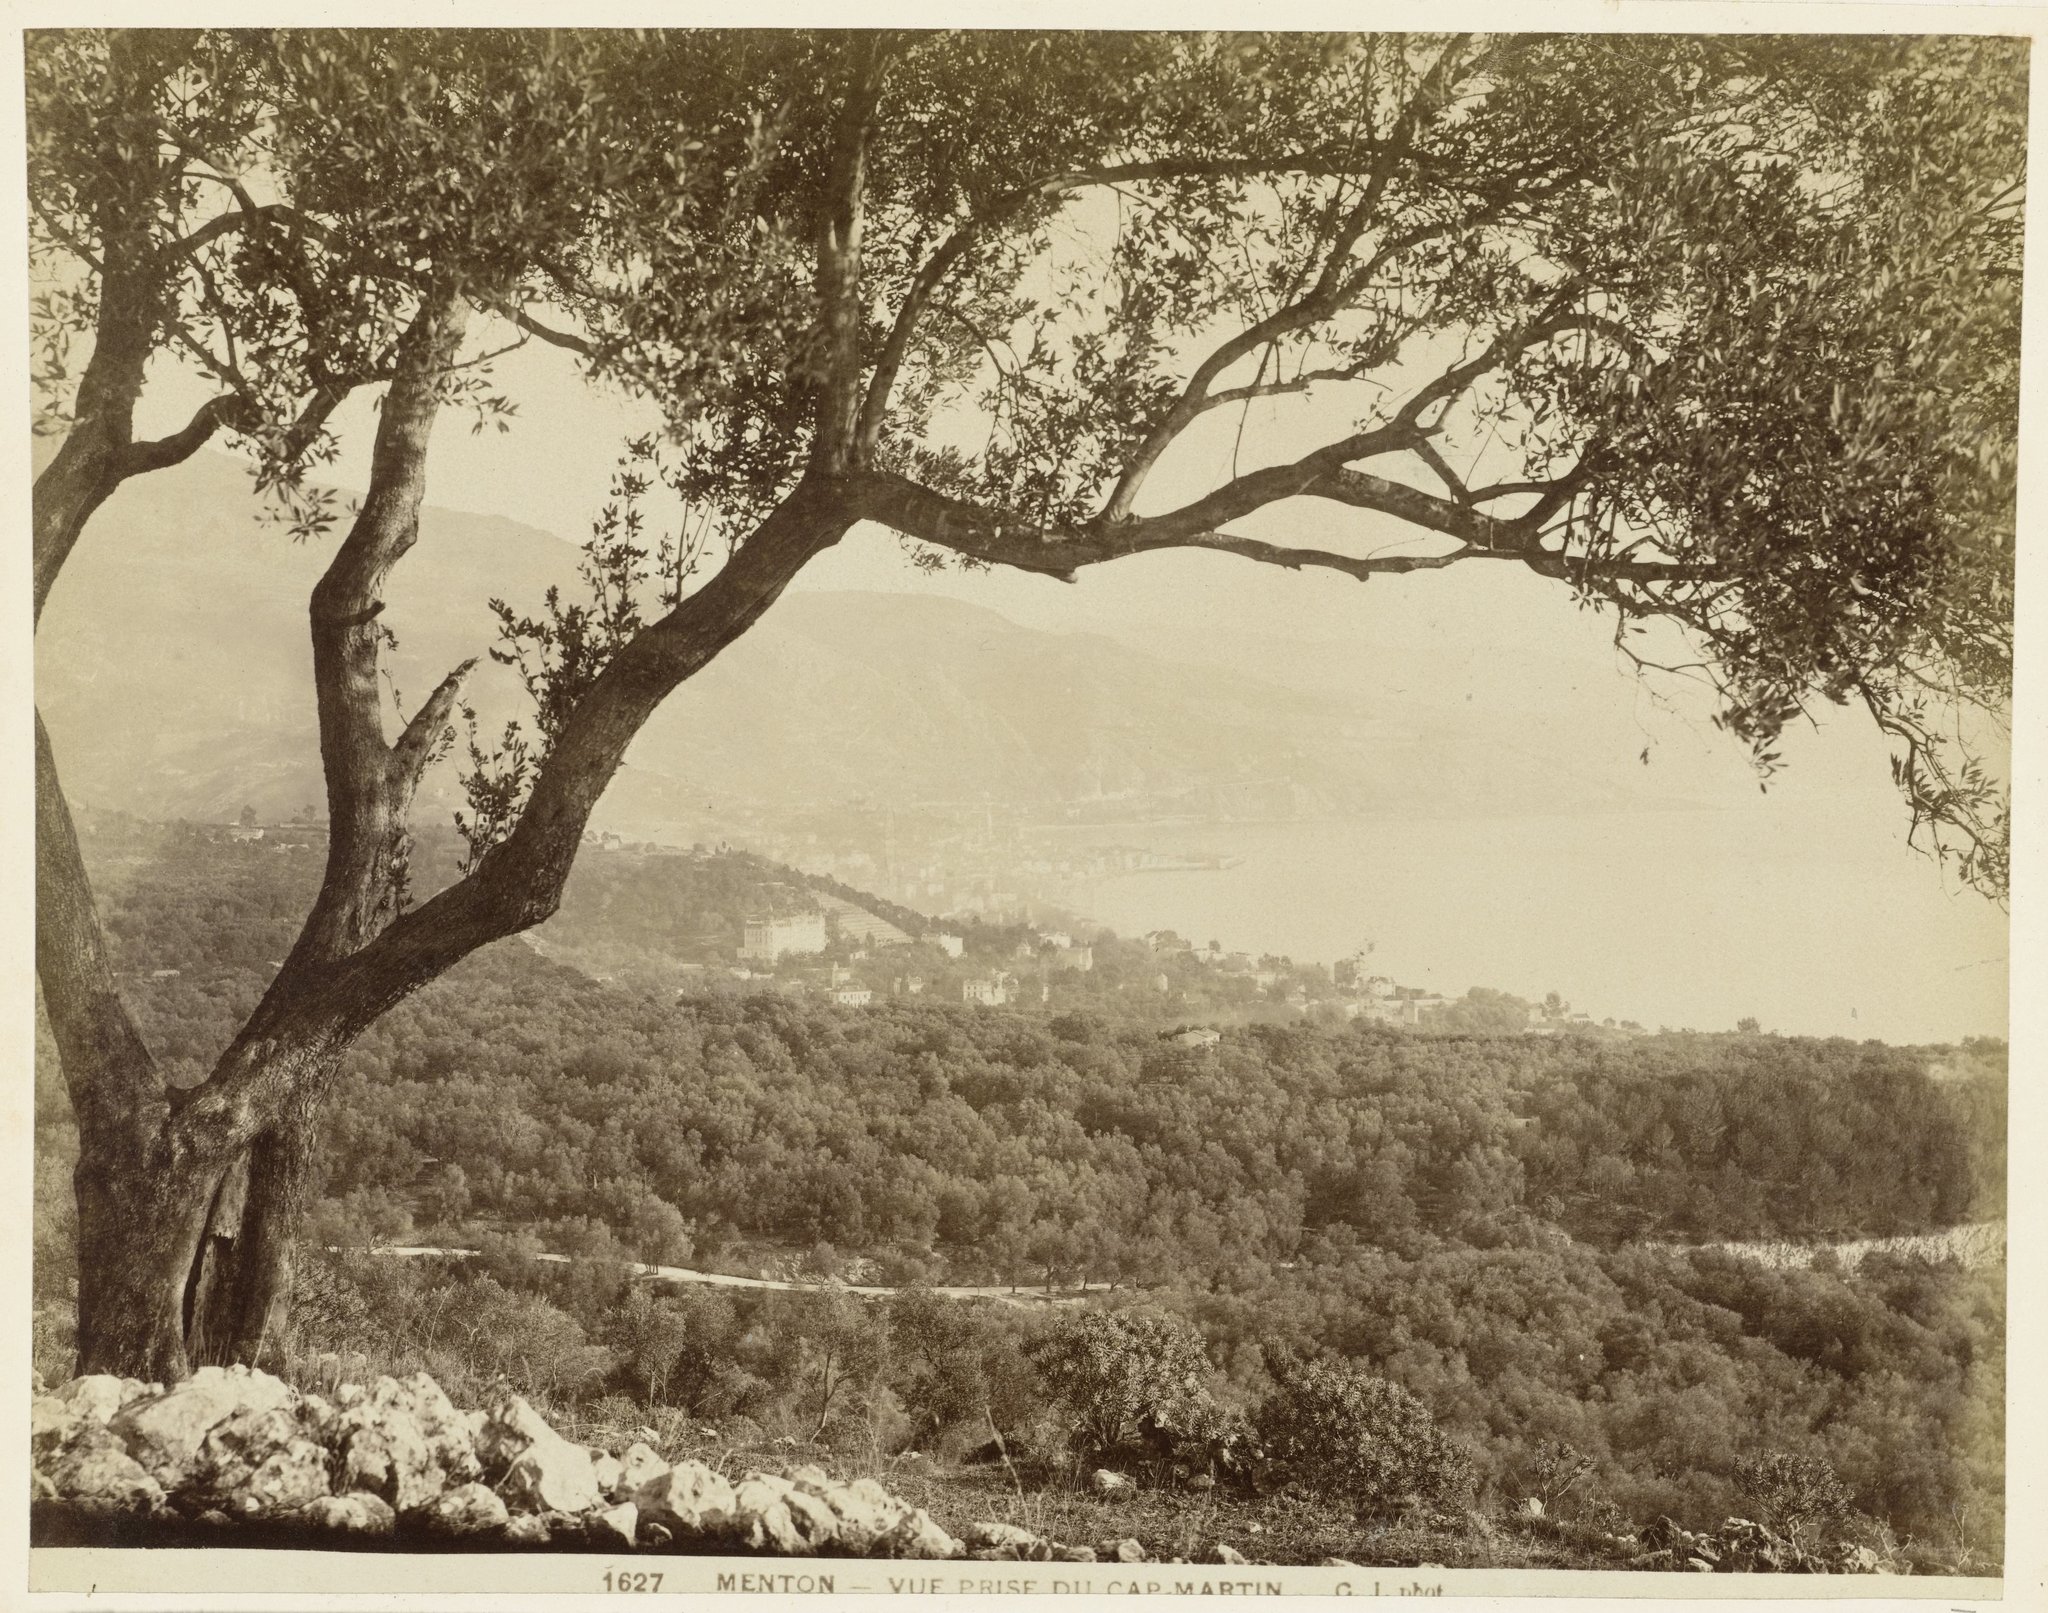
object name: photograph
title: Gezicht op Cap Martin en omgeving gezien vanuit Menton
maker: henry pauw van wieldrecht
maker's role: fotograaf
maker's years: 1863-1912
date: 1886-1896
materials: cardboard, photographic support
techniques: albumen print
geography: france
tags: menton